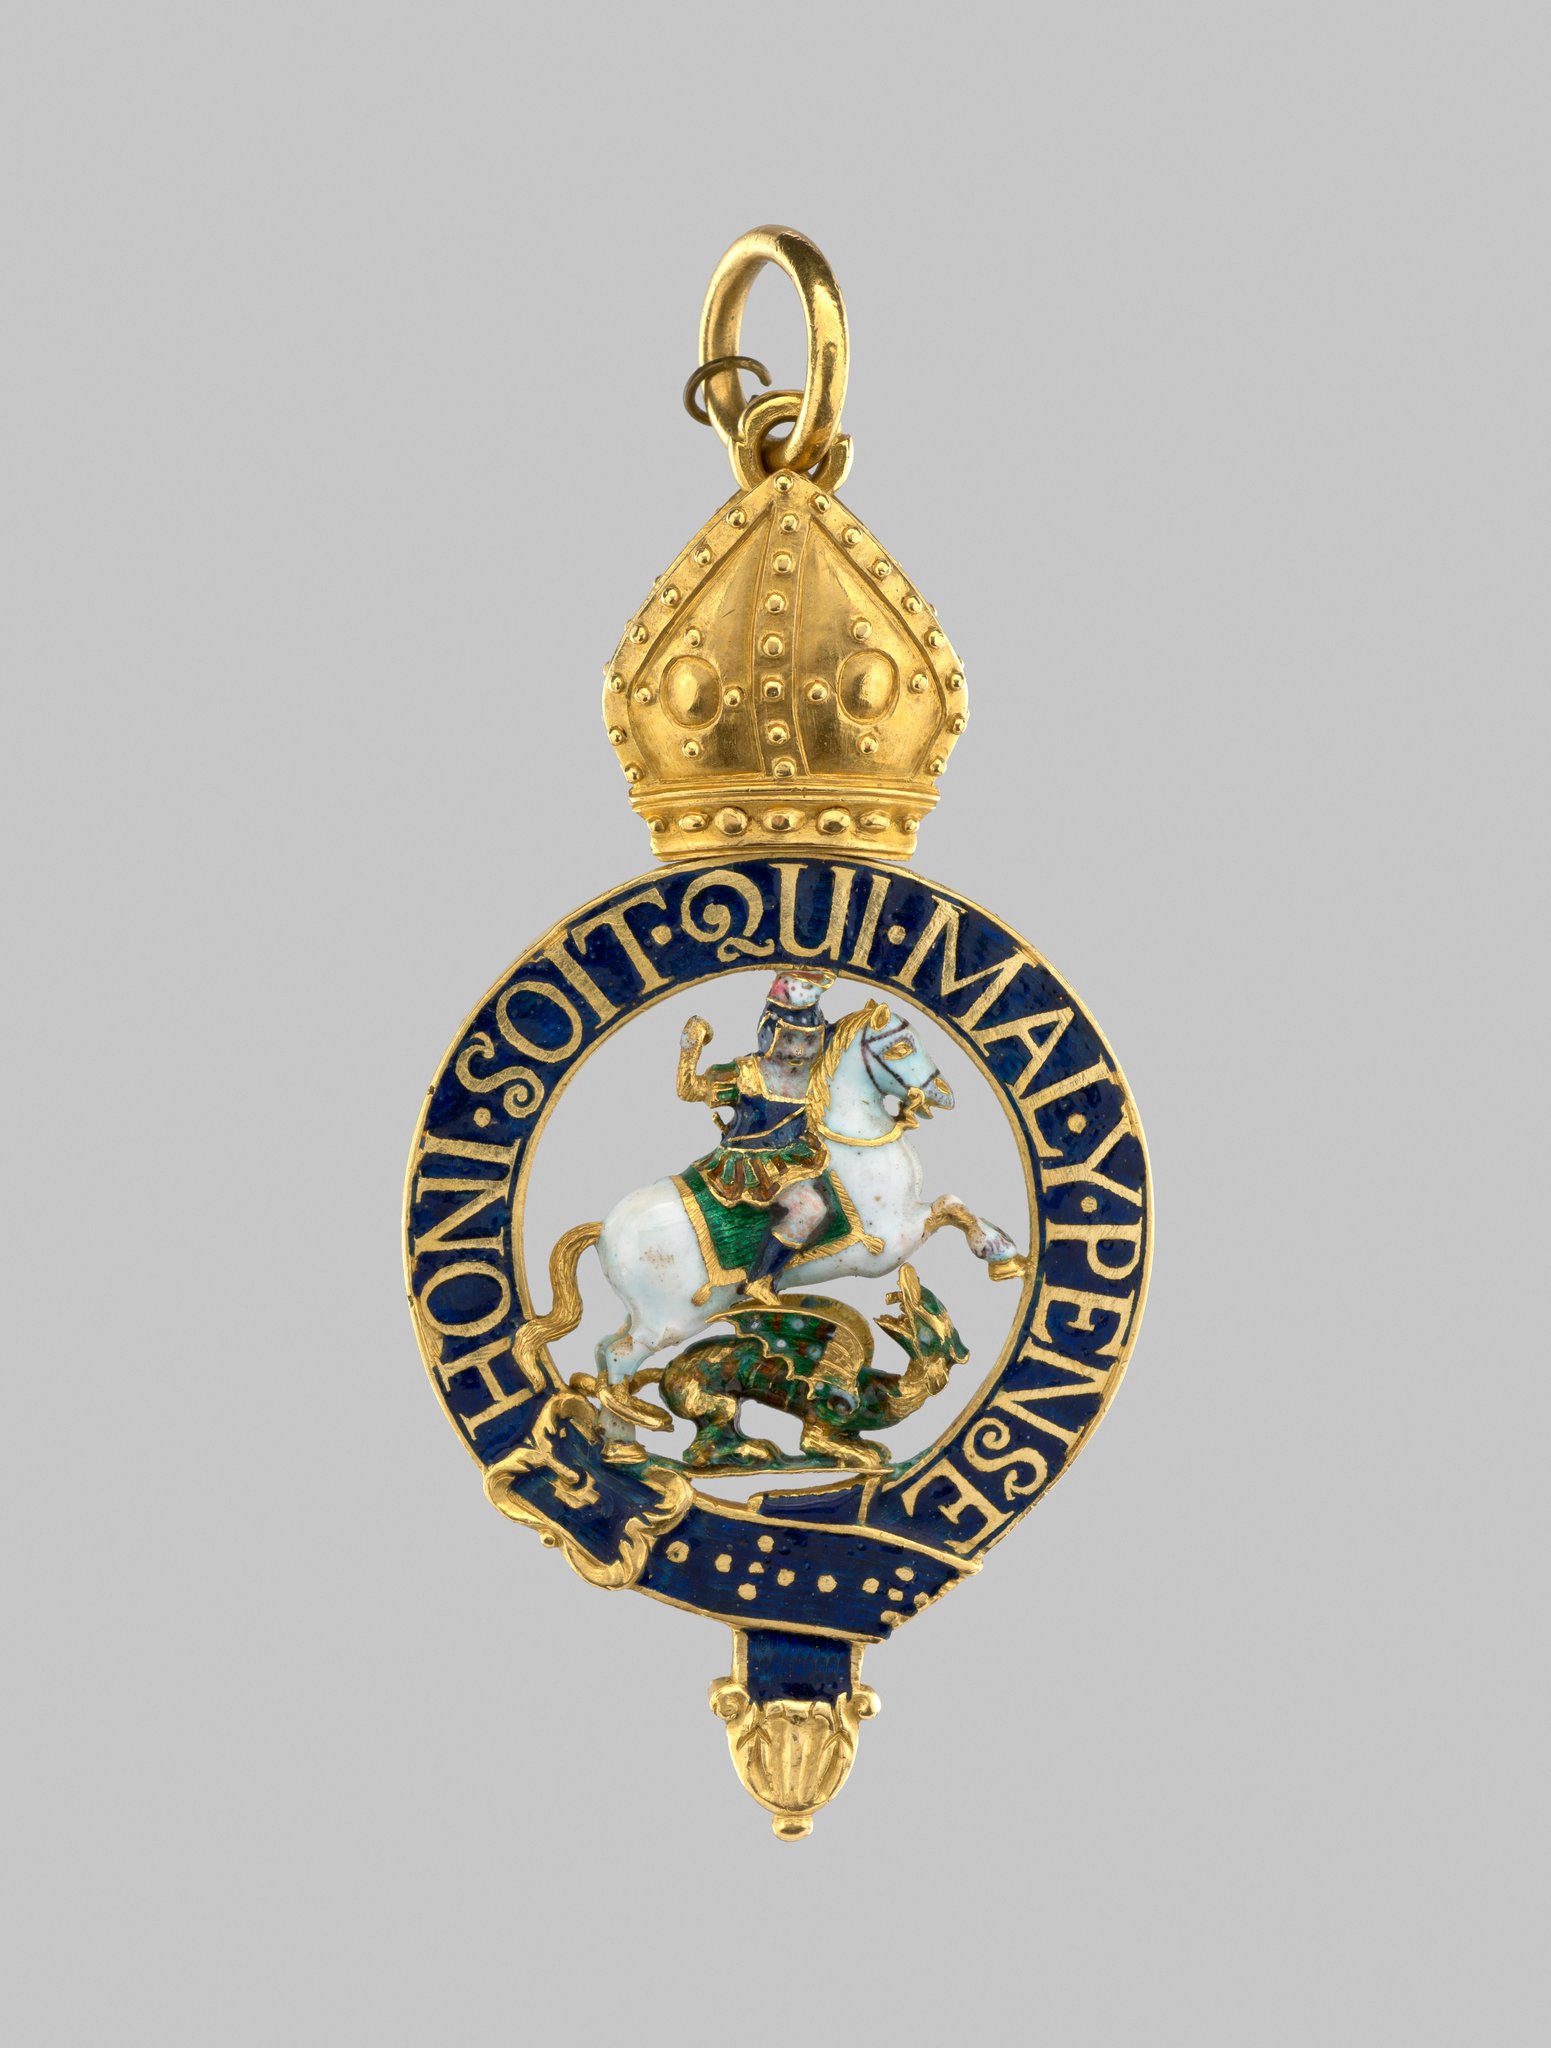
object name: badge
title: Badge of the Order of the Garter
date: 1701-1800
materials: enamel, gold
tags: dragons,horses,saint michael